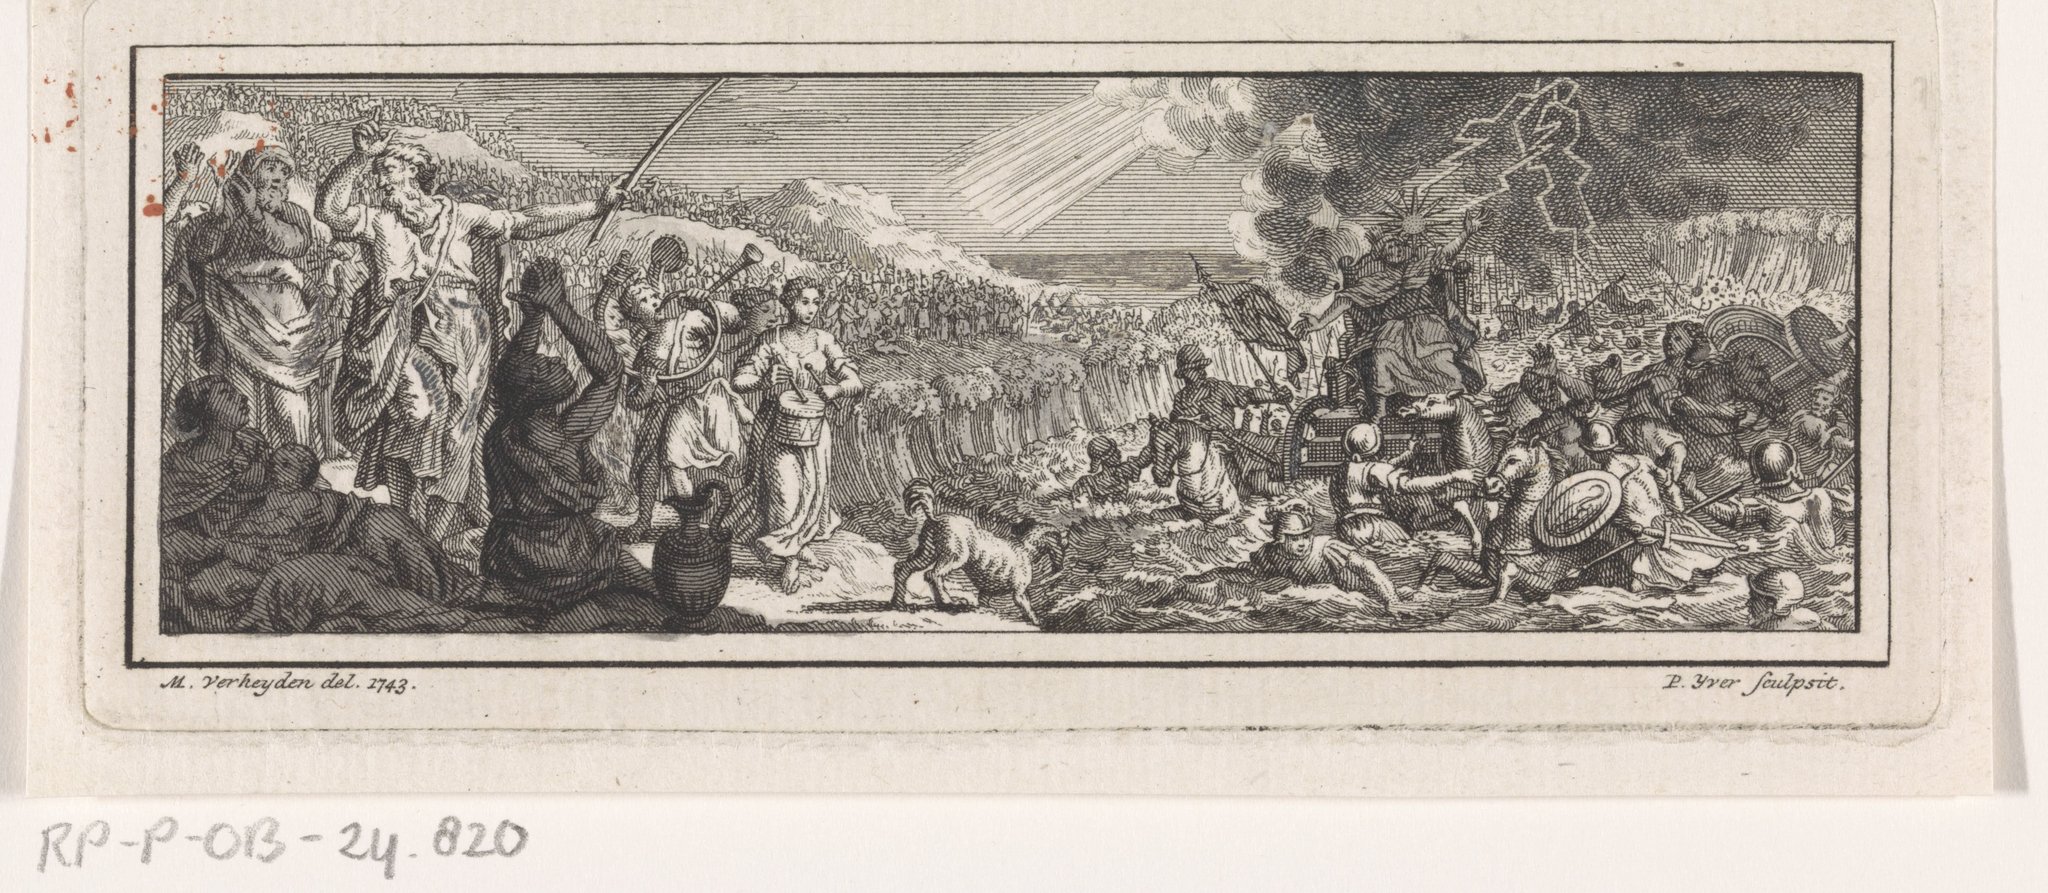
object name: print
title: Doortocht door de Rode Zee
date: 1743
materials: paper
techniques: engraving, etching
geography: amsterdam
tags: with his people safe on the shore, moses raises his hands and causes the water to return; pharaoh's army perishes in the water (red sea)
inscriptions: collector's mark: Lugt 240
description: Het volk van Israël staat veilig aan de overkant, nadat het door de Rode Zee is getrokken. Mozes heft zijn staf om het water terug te laten vloeien. Farao en zijn leger worden verzwolgen in de golven.